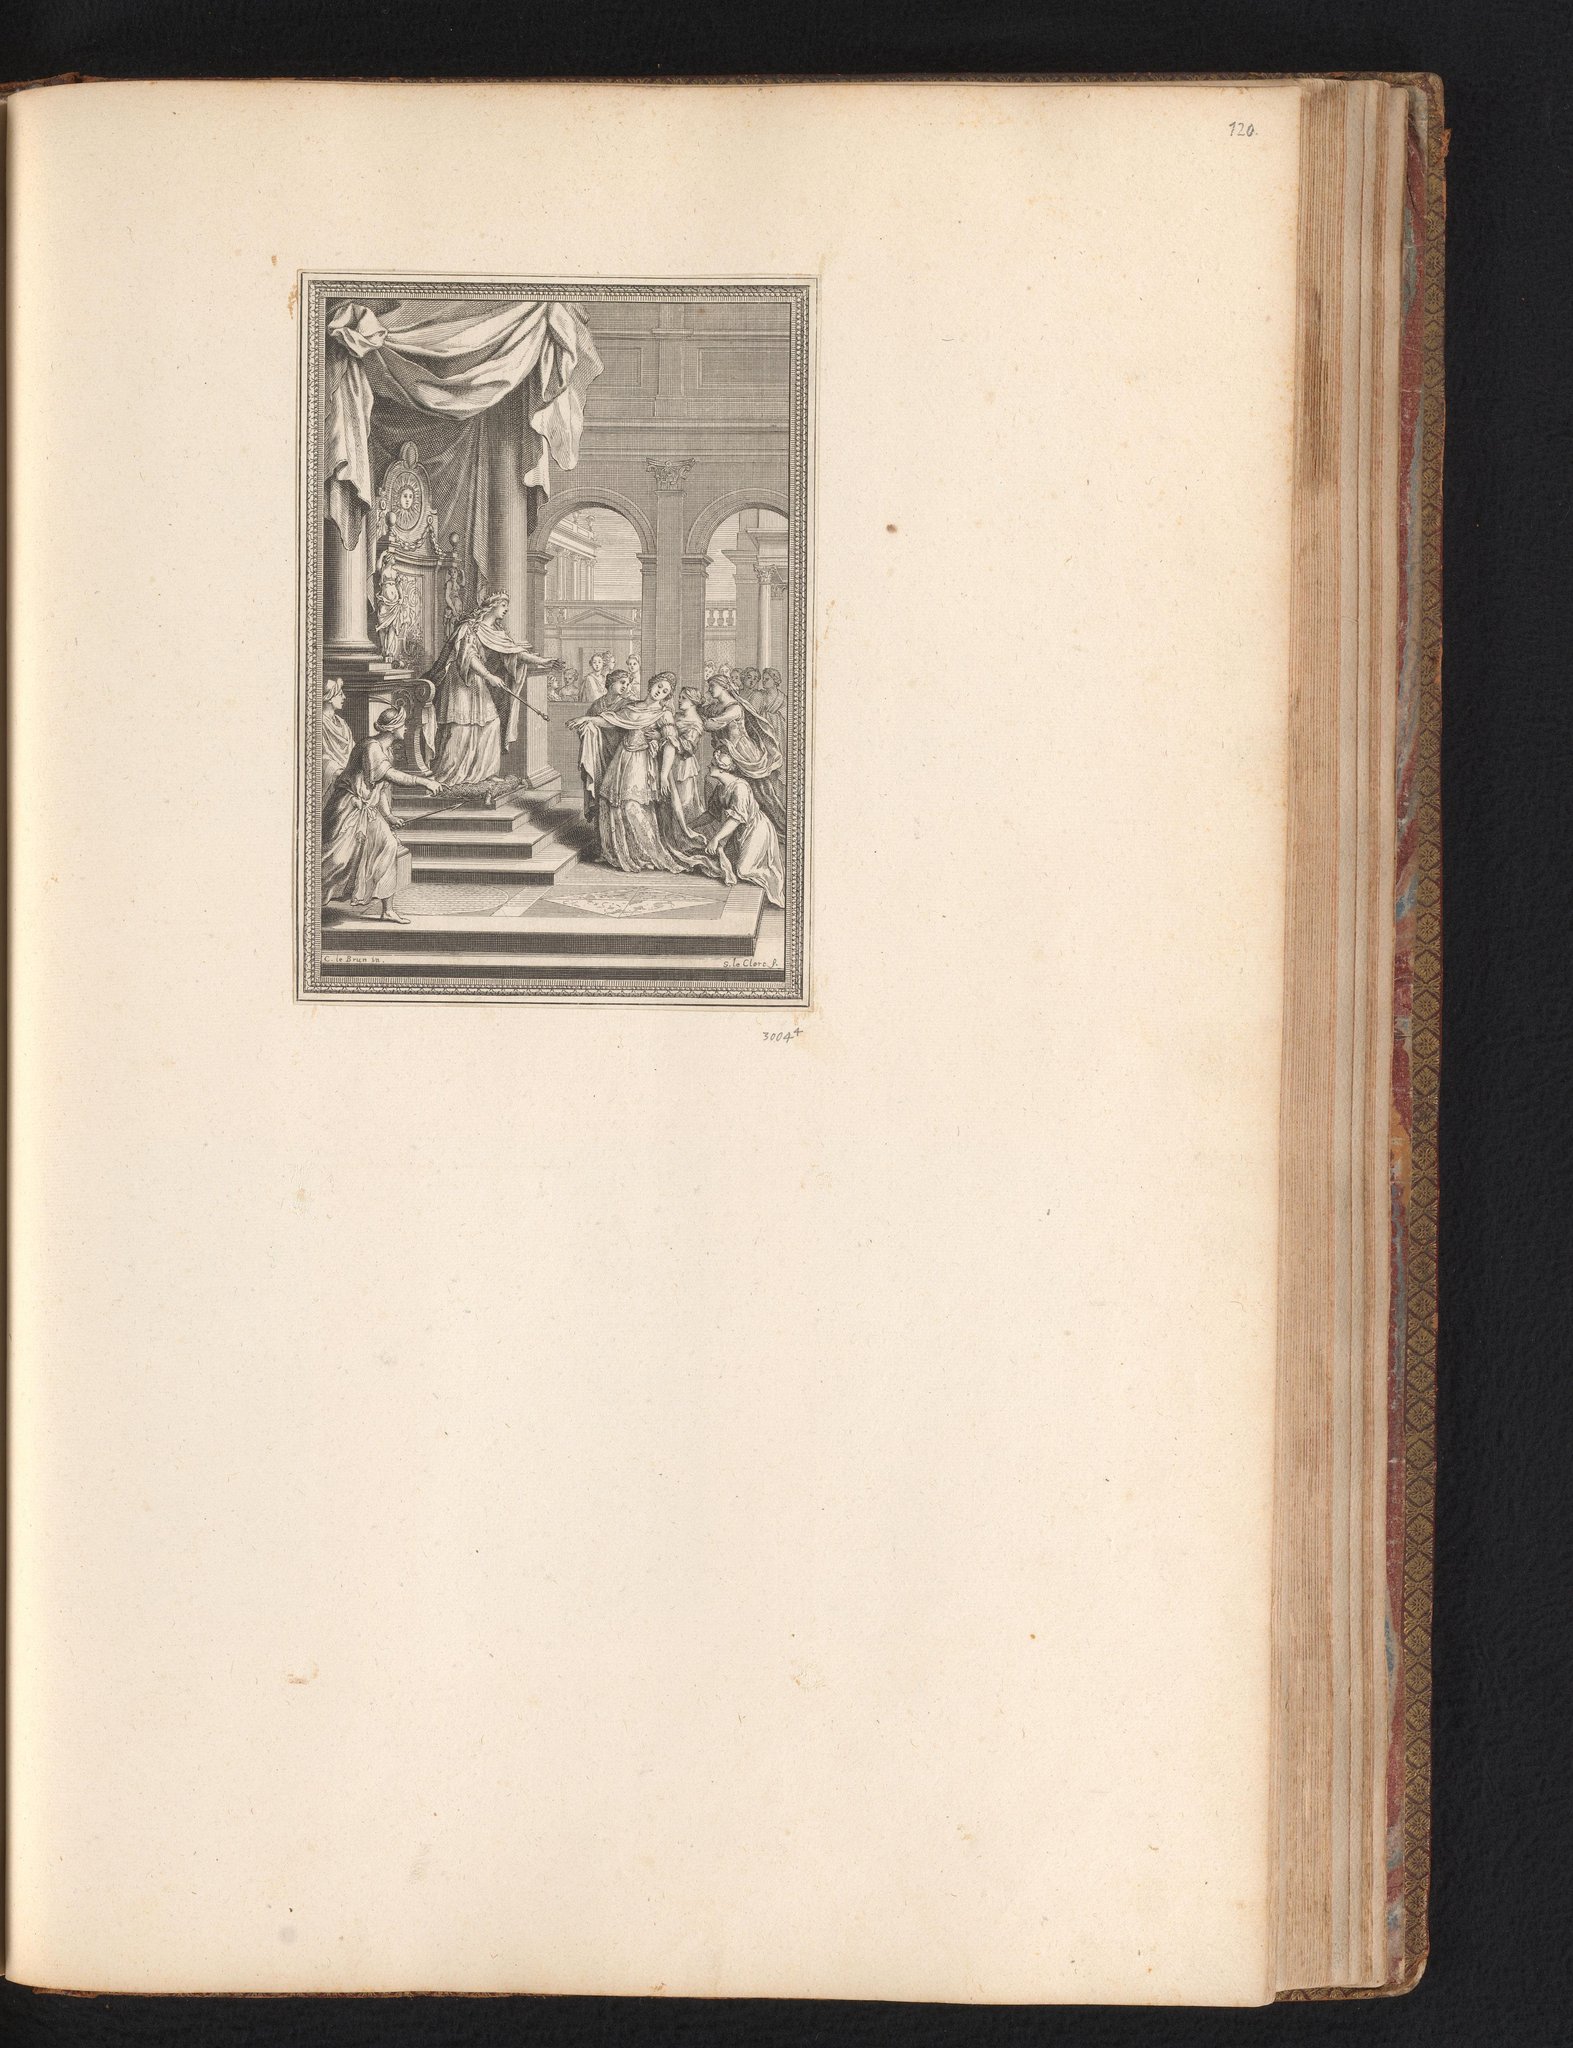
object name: album leaf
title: Esther voor Ahasveros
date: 1689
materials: paper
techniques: etching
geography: paris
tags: esther before ahasuerus (esther 5:1-4), title-page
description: Prent uit: Racine, Jean. Esther, Tragédie tirée de l'Escriture Sainte (...). Parijs: Denis Thierry, 1689.